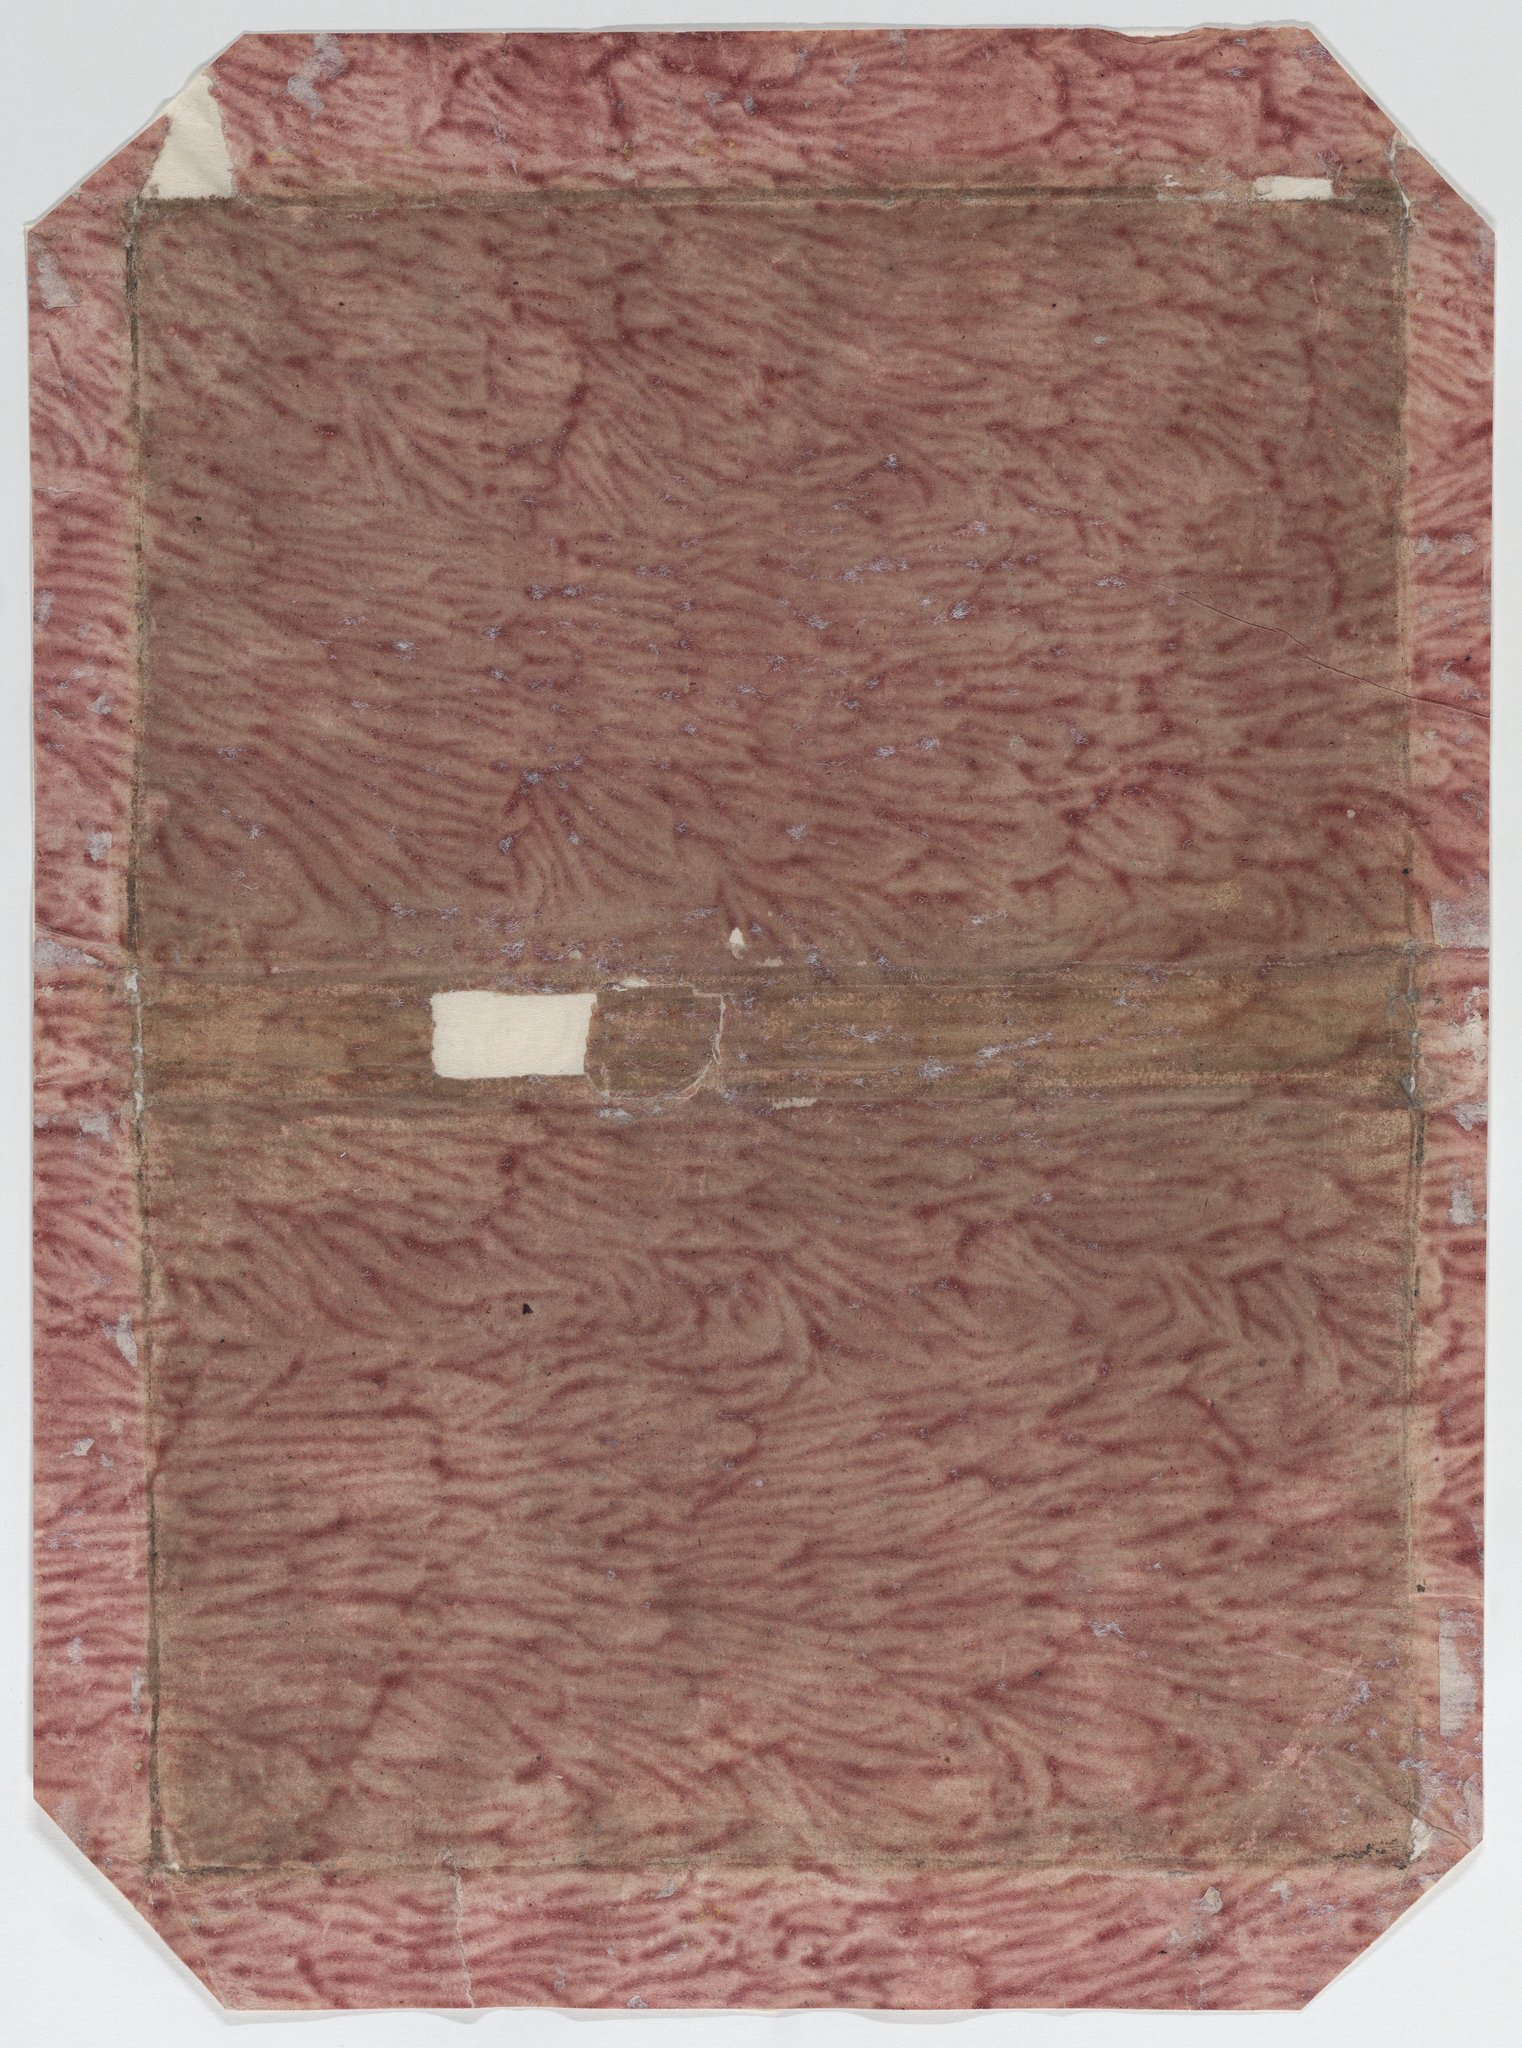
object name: print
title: Red paste paper book cover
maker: Anonymous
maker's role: artist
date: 1701-1800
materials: paper, paste